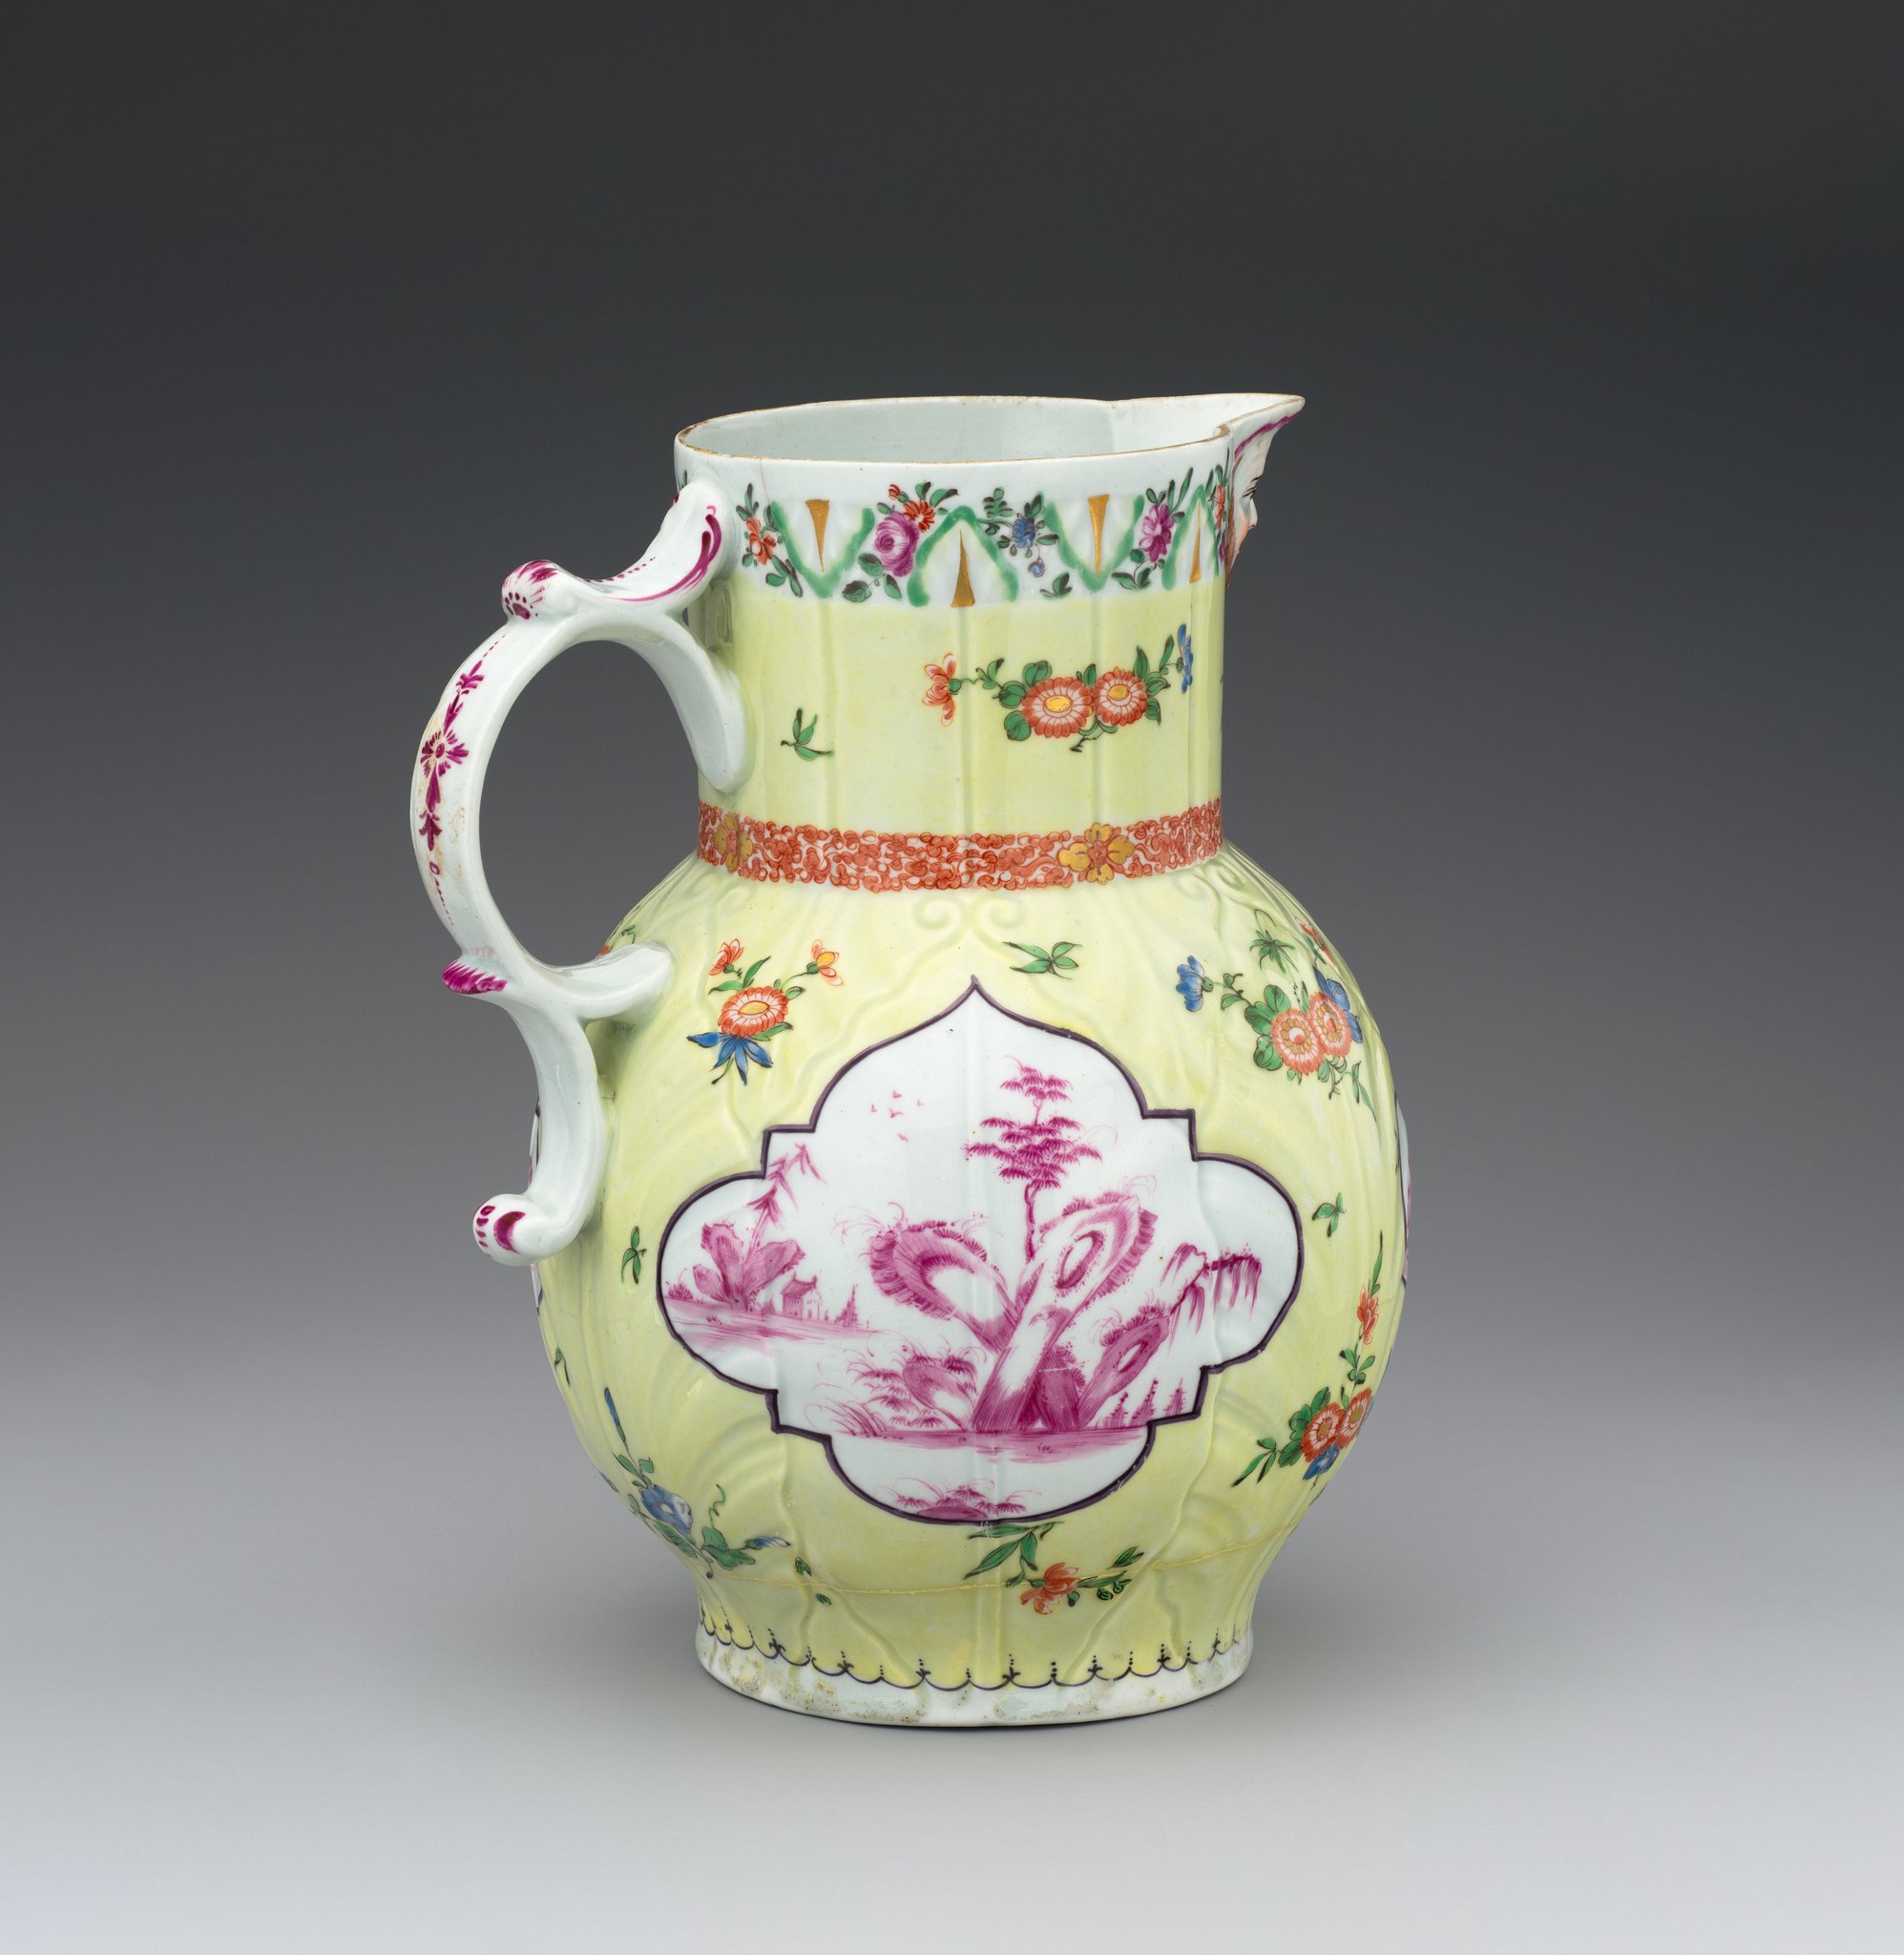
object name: jug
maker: worcester factory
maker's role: factory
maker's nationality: british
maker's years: 1751-2008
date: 1765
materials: soft paste porcelain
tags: flowers